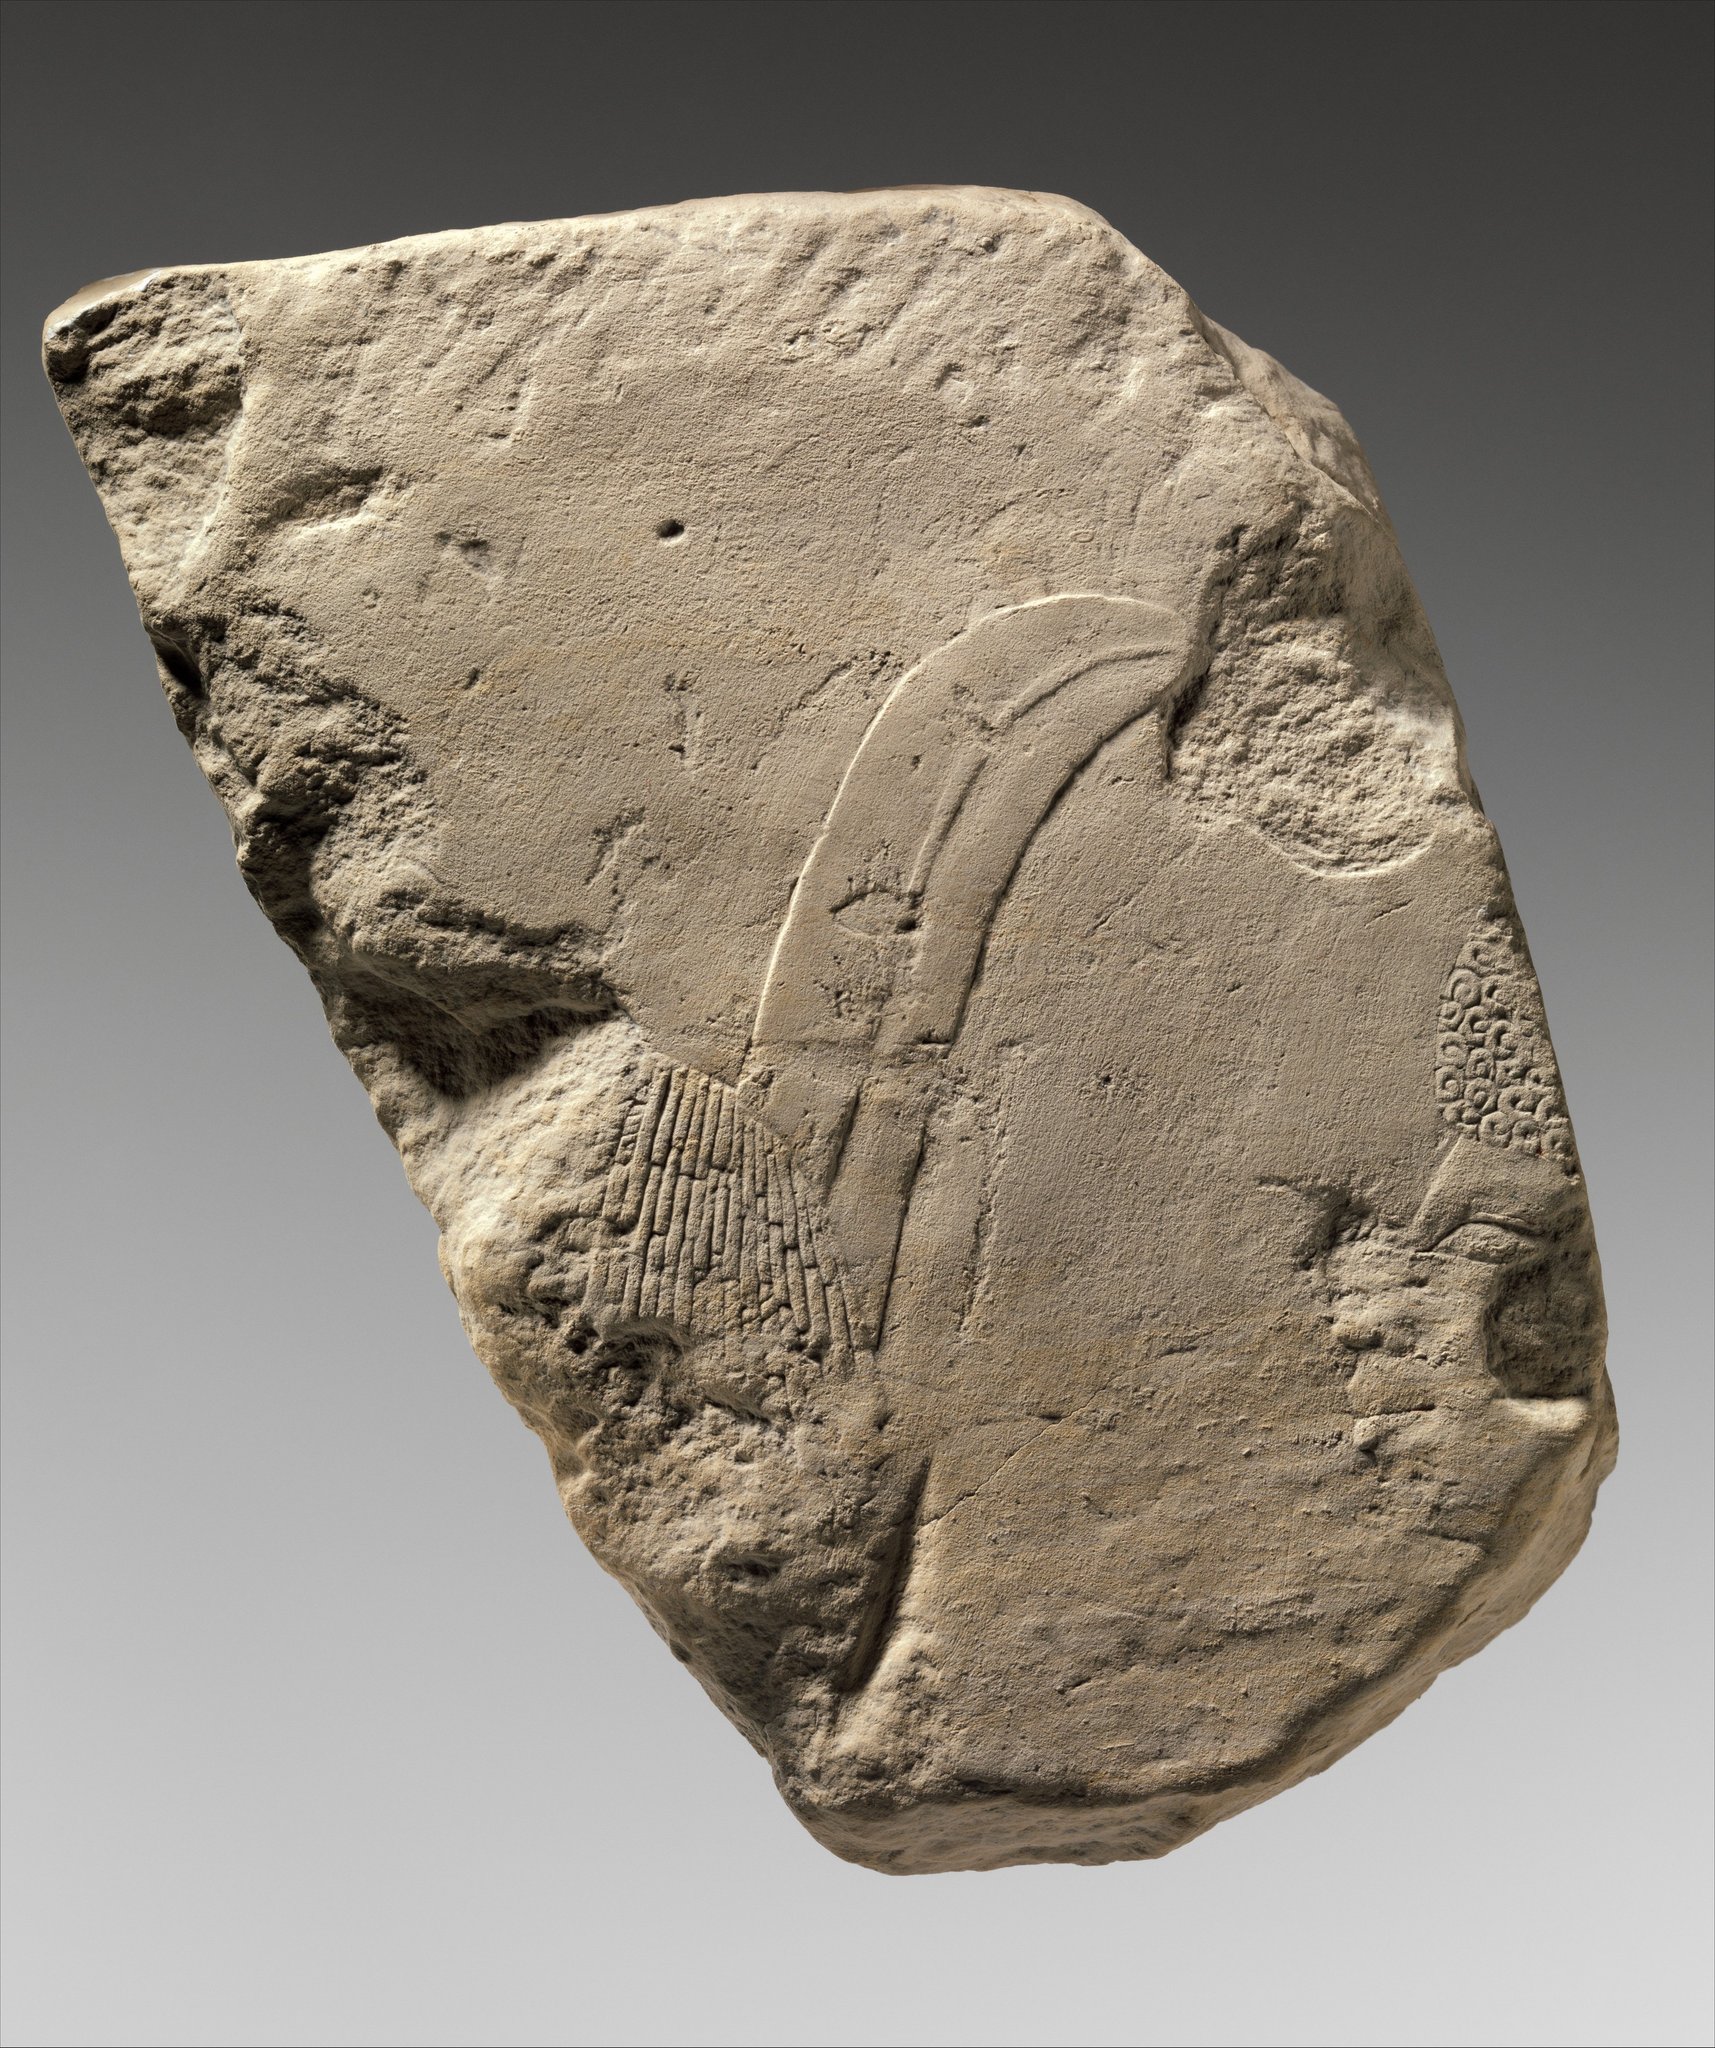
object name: relief, senwosret i, nubian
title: Relief fragment: foreigner with feather in his hair and Nubian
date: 1961-1917 BCE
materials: limestone, paint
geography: egypt